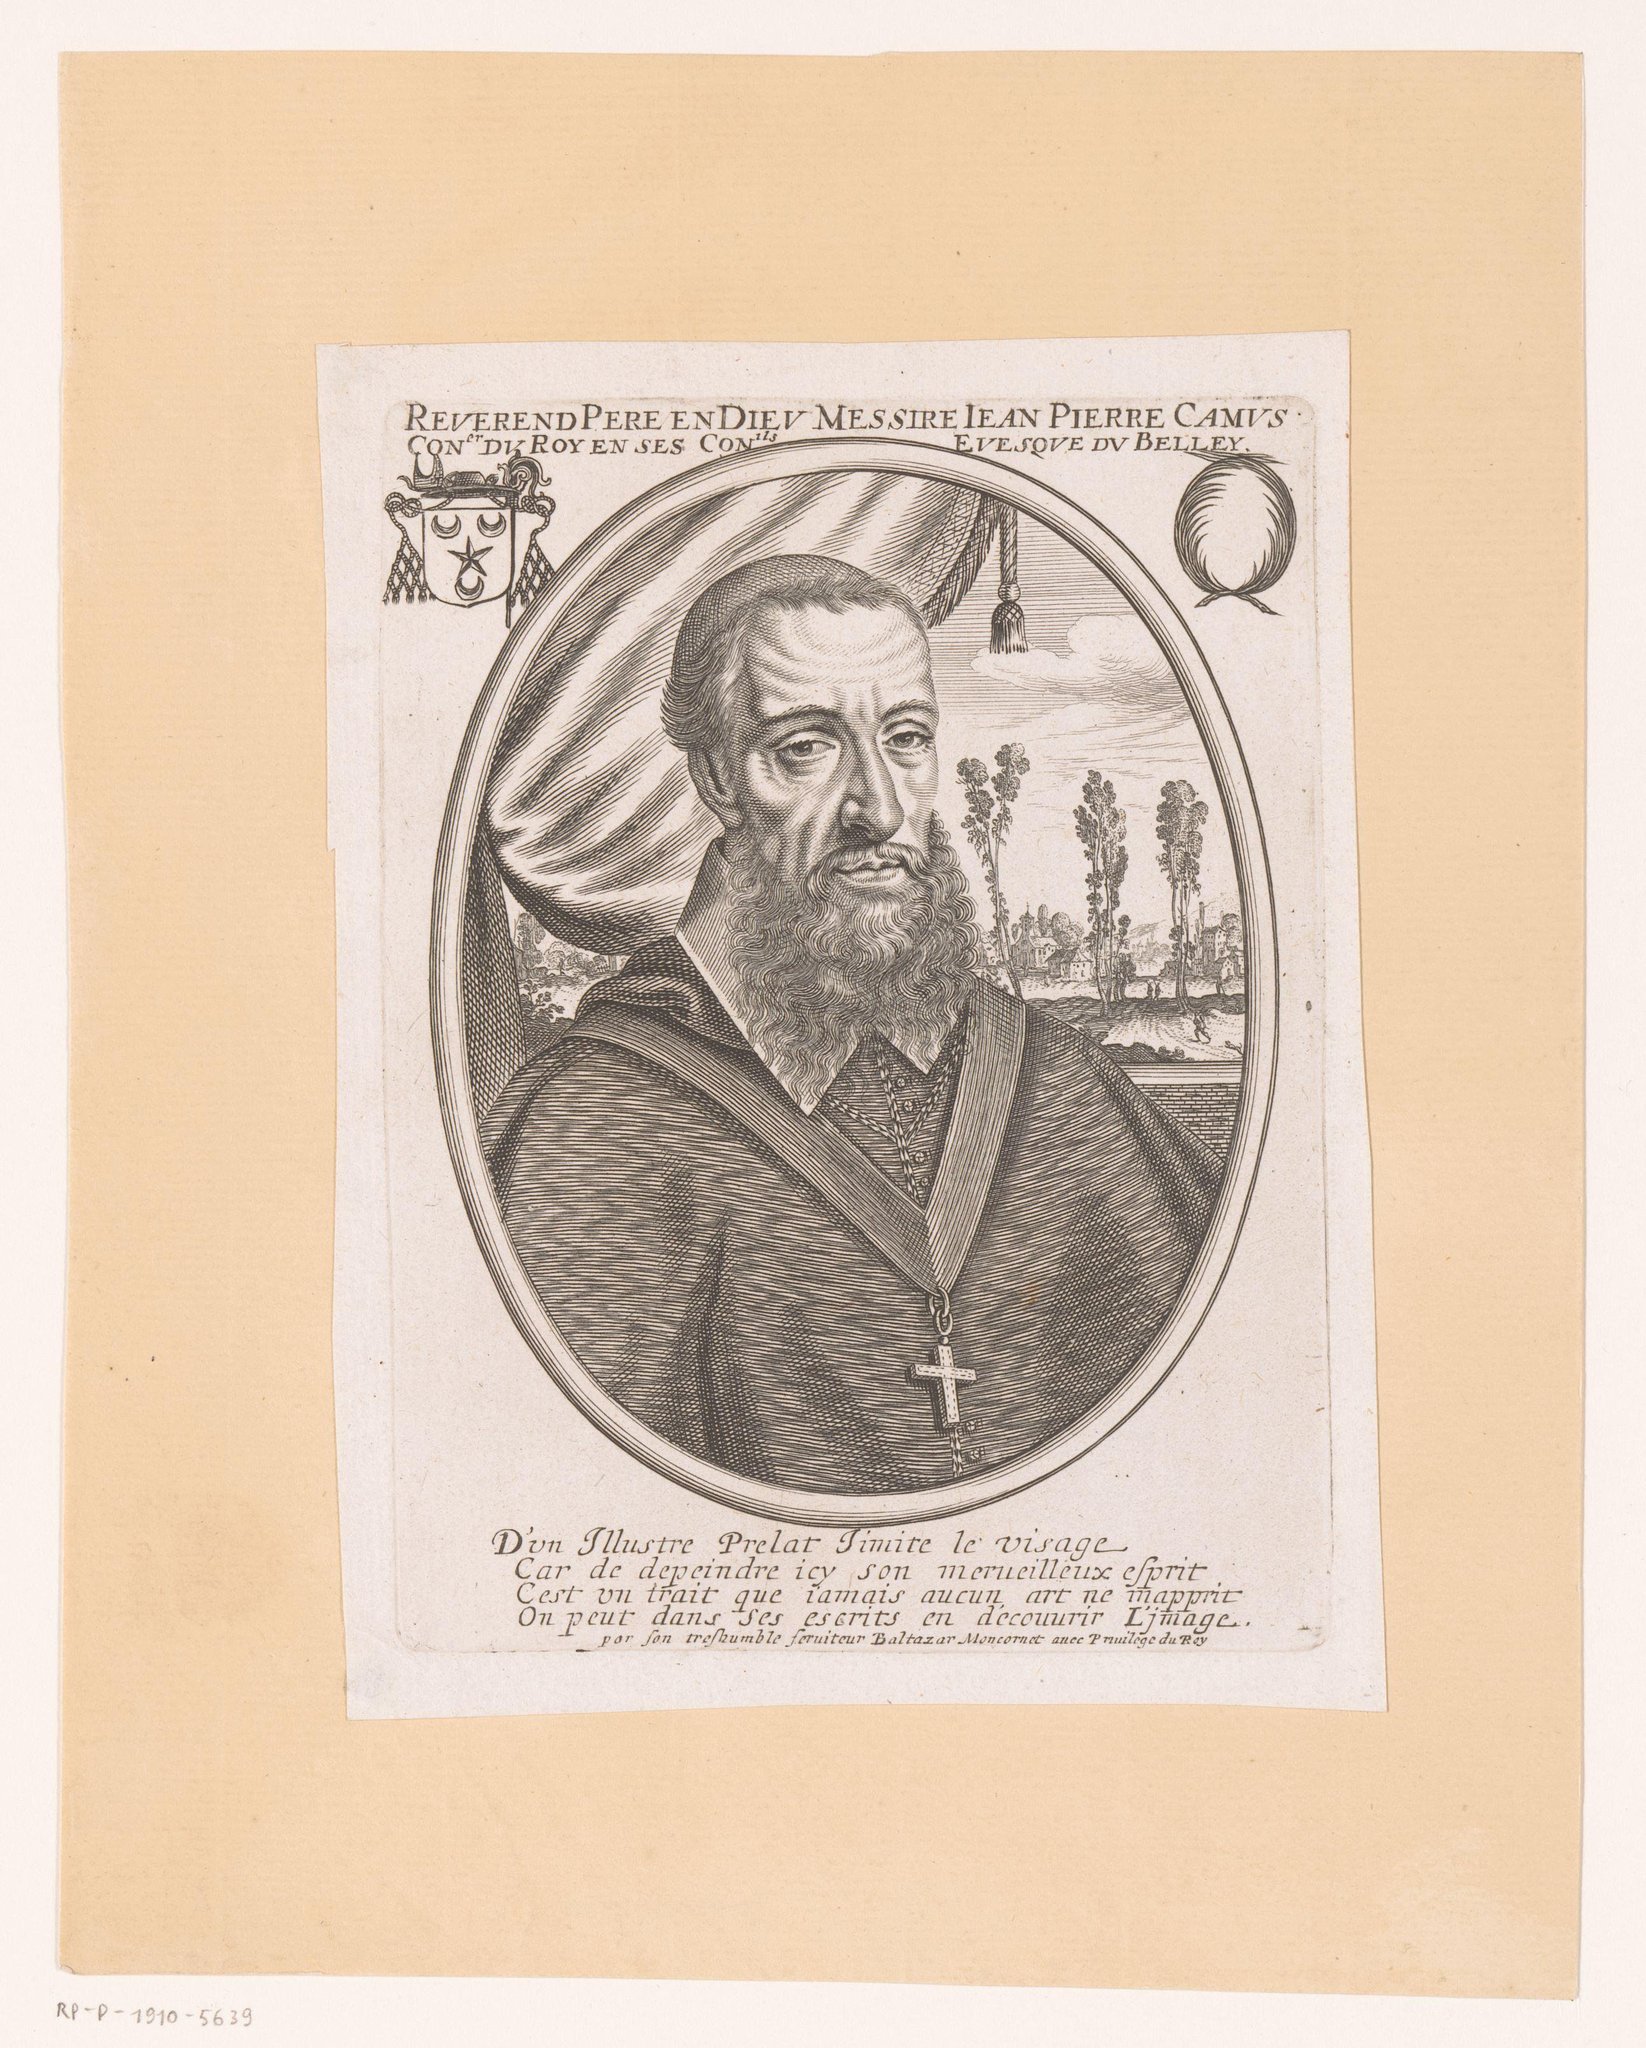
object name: print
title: Portret van Karol Ferdynand Vasa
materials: paper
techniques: engraving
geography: paris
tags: priest, prince, historical persons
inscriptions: collector's mark: Lugt 2228